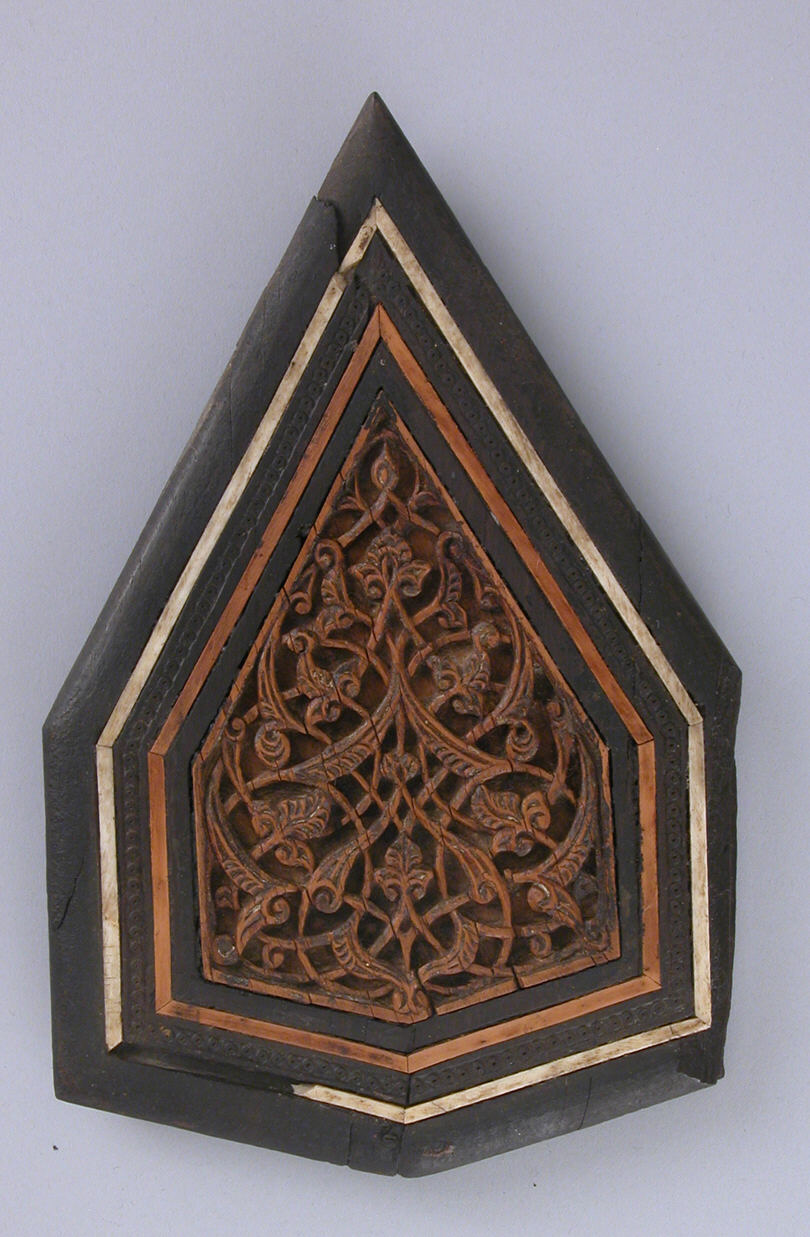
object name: panel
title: Panel from a Minbar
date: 1201-1400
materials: ivory, paint, wood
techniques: carving, inlay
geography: egypt